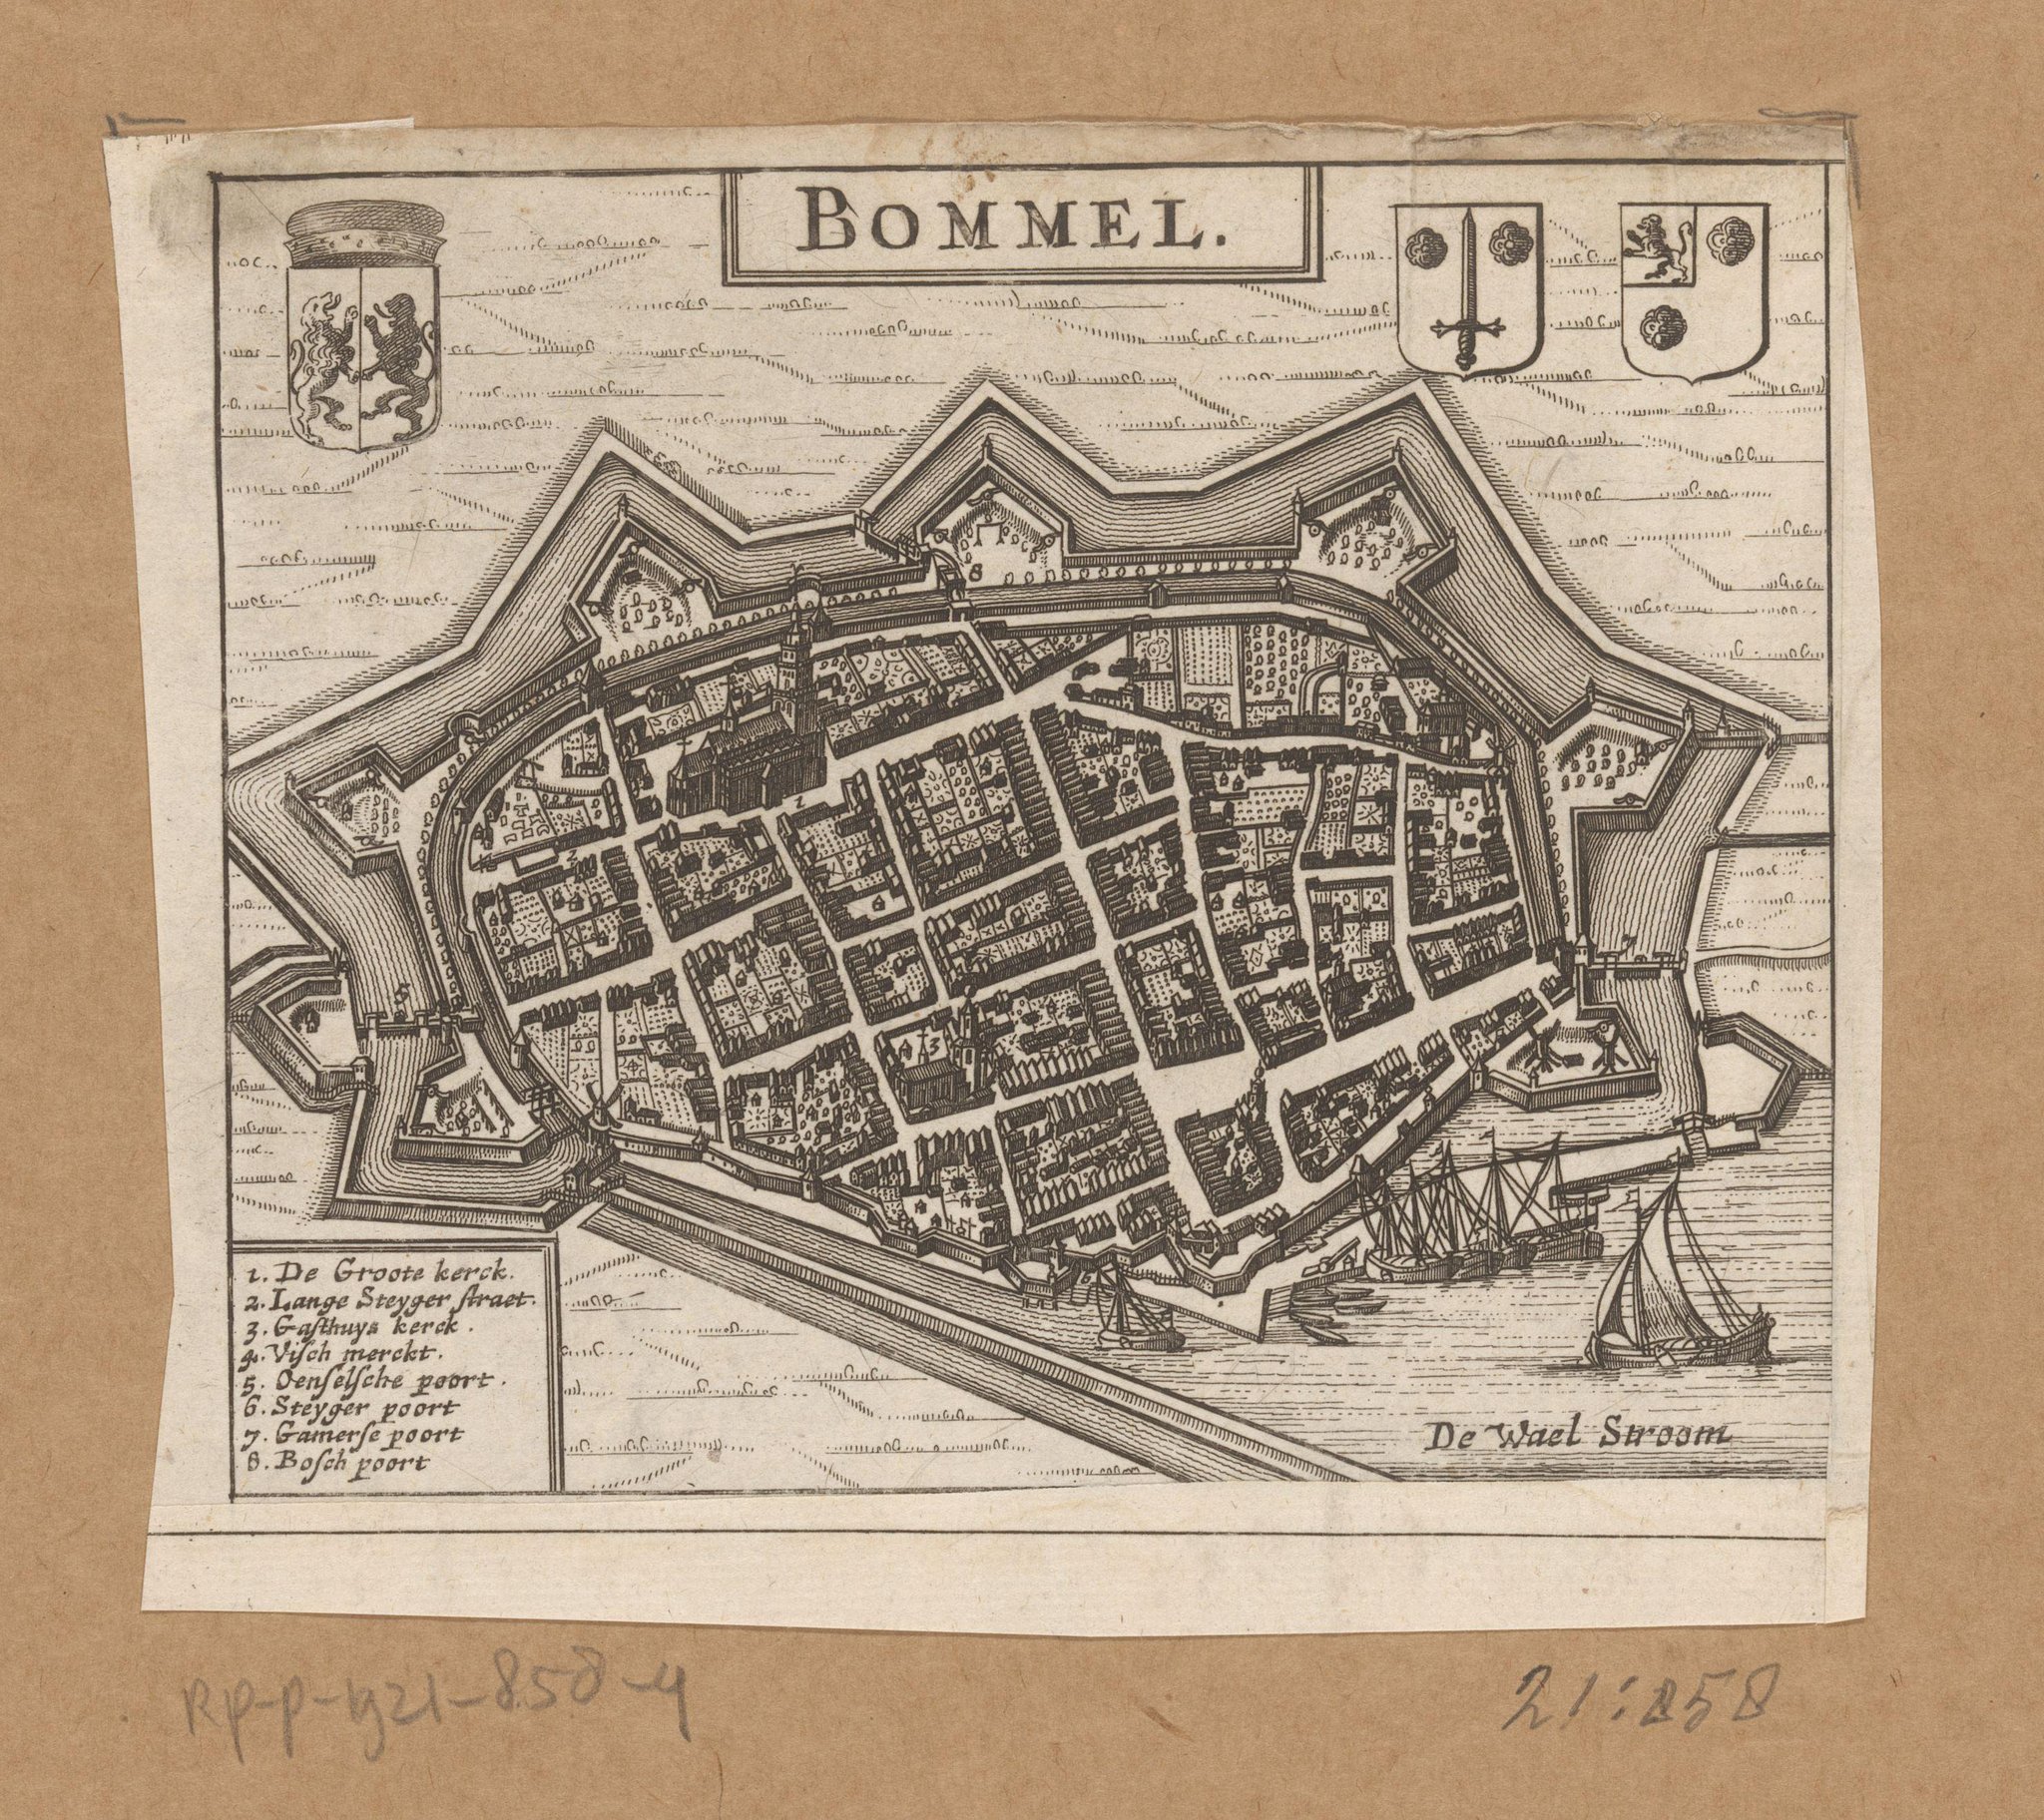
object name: print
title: Plattegrond van Zaltbommel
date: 1660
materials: paper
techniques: etching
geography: amsterdam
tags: maps of cities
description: Prent uit: Guicciardini, Lodovico. Belgicae sive inferioris Germaniae Descriptio (...). Amsterdam: Jacob van Meurs, 1660.